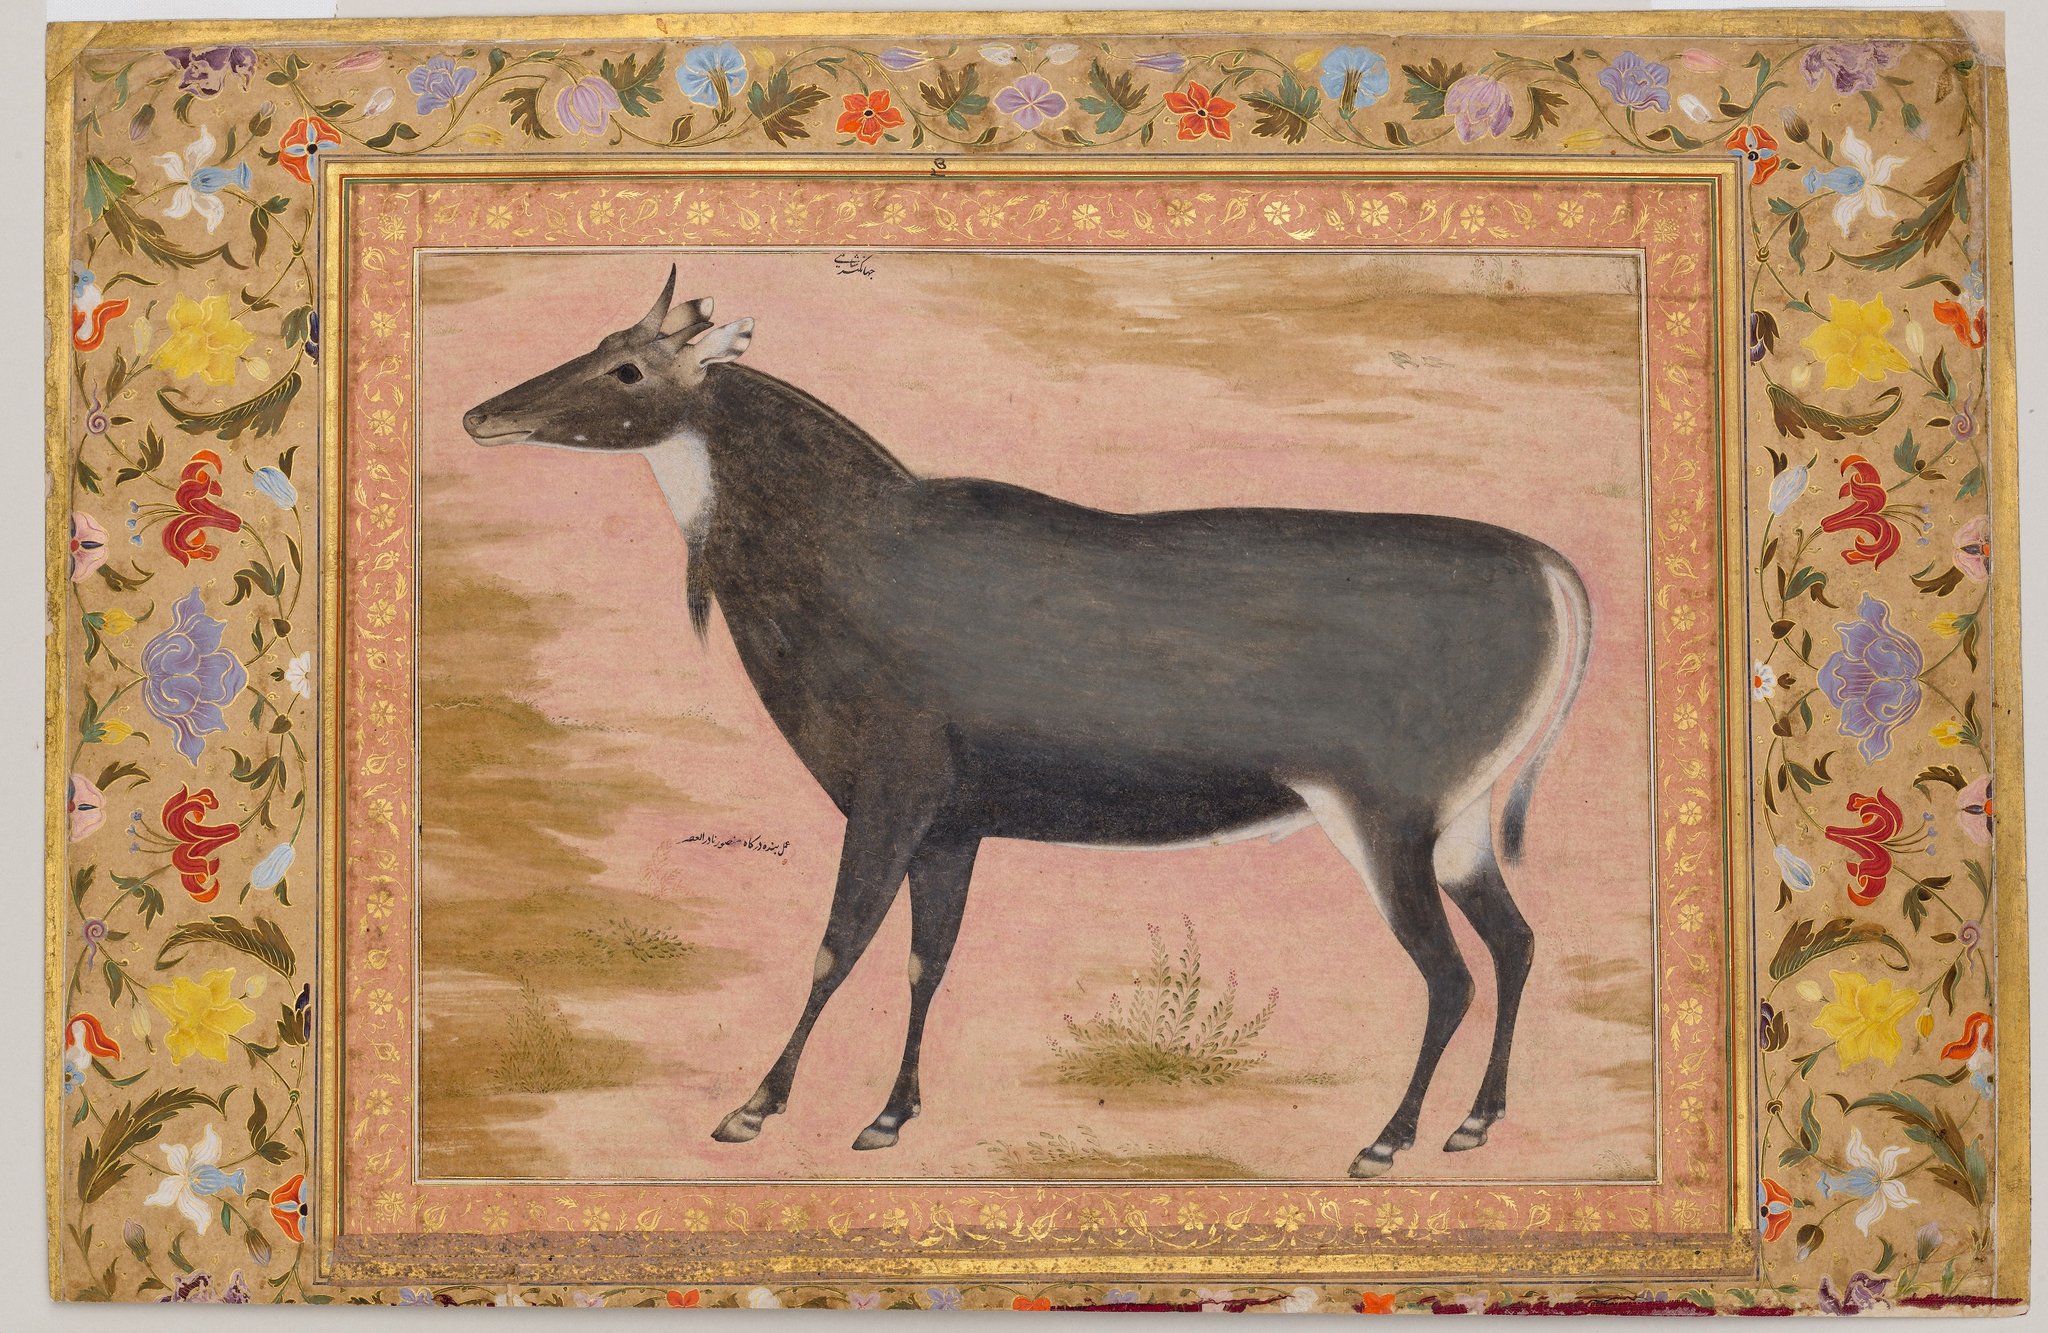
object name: album leaf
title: "Study of a Nilgai (Blue Bull)", Folio from the Shah Jahan Album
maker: mansur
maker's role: artist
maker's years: 1584-1626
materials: gold, ink, paper, watercolor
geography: india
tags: bulls